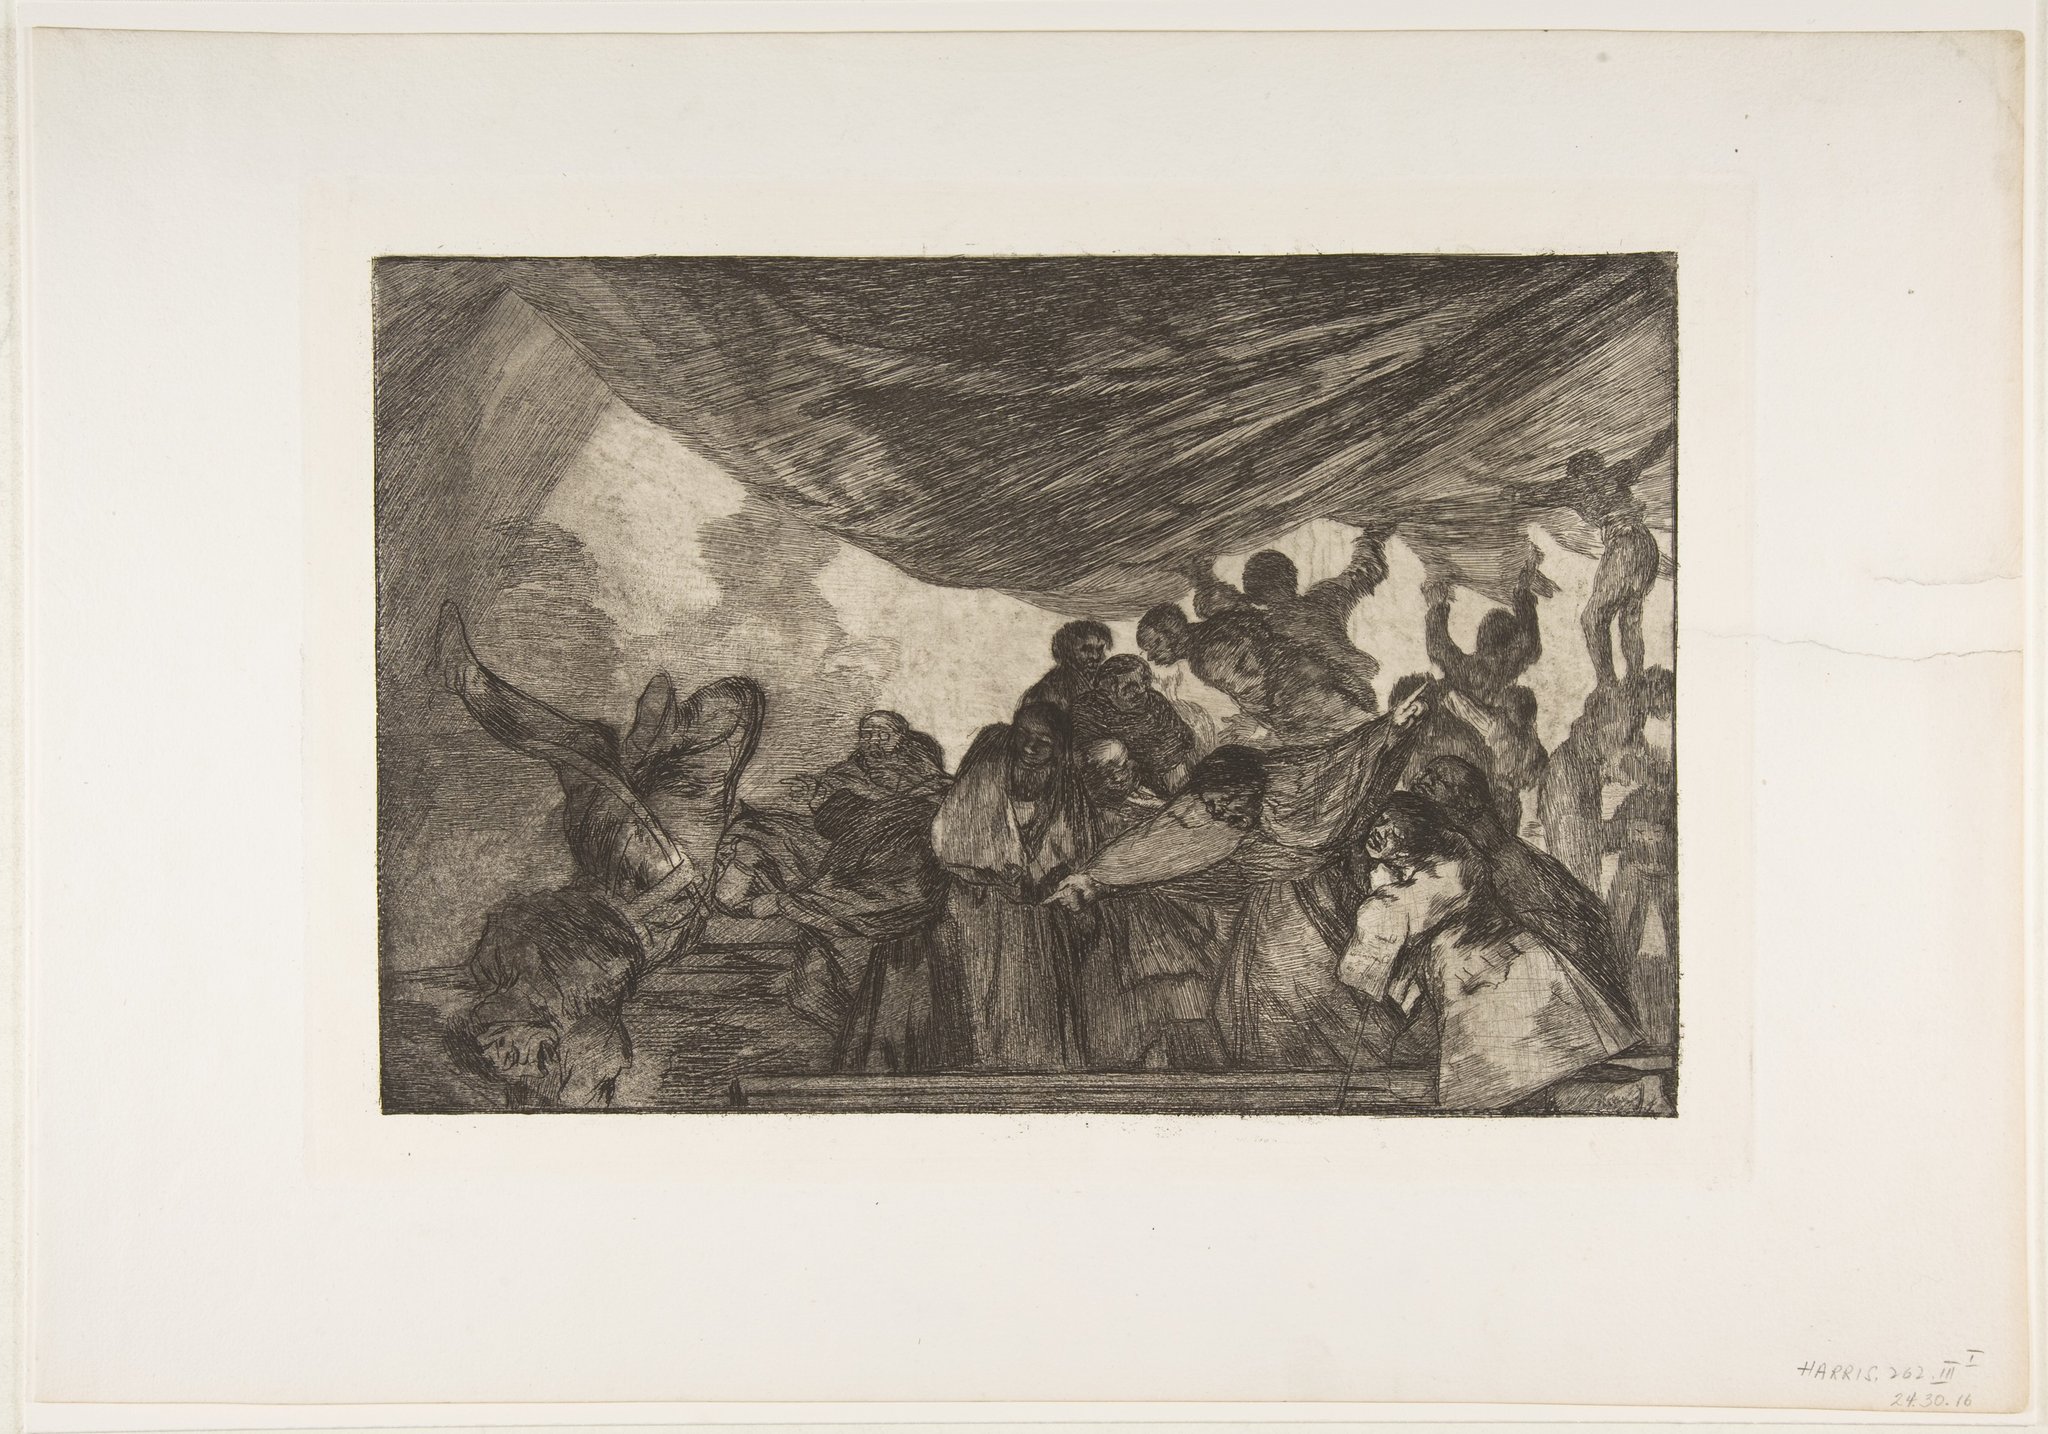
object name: print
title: Clear Folly, from "The Disparates" (Follies / Irrationalities)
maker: goya (francisco de goya y lucientes)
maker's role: artist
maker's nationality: spanish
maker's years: 1746-1828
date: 1815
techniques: aquatint, burnishing, etching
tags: men,women